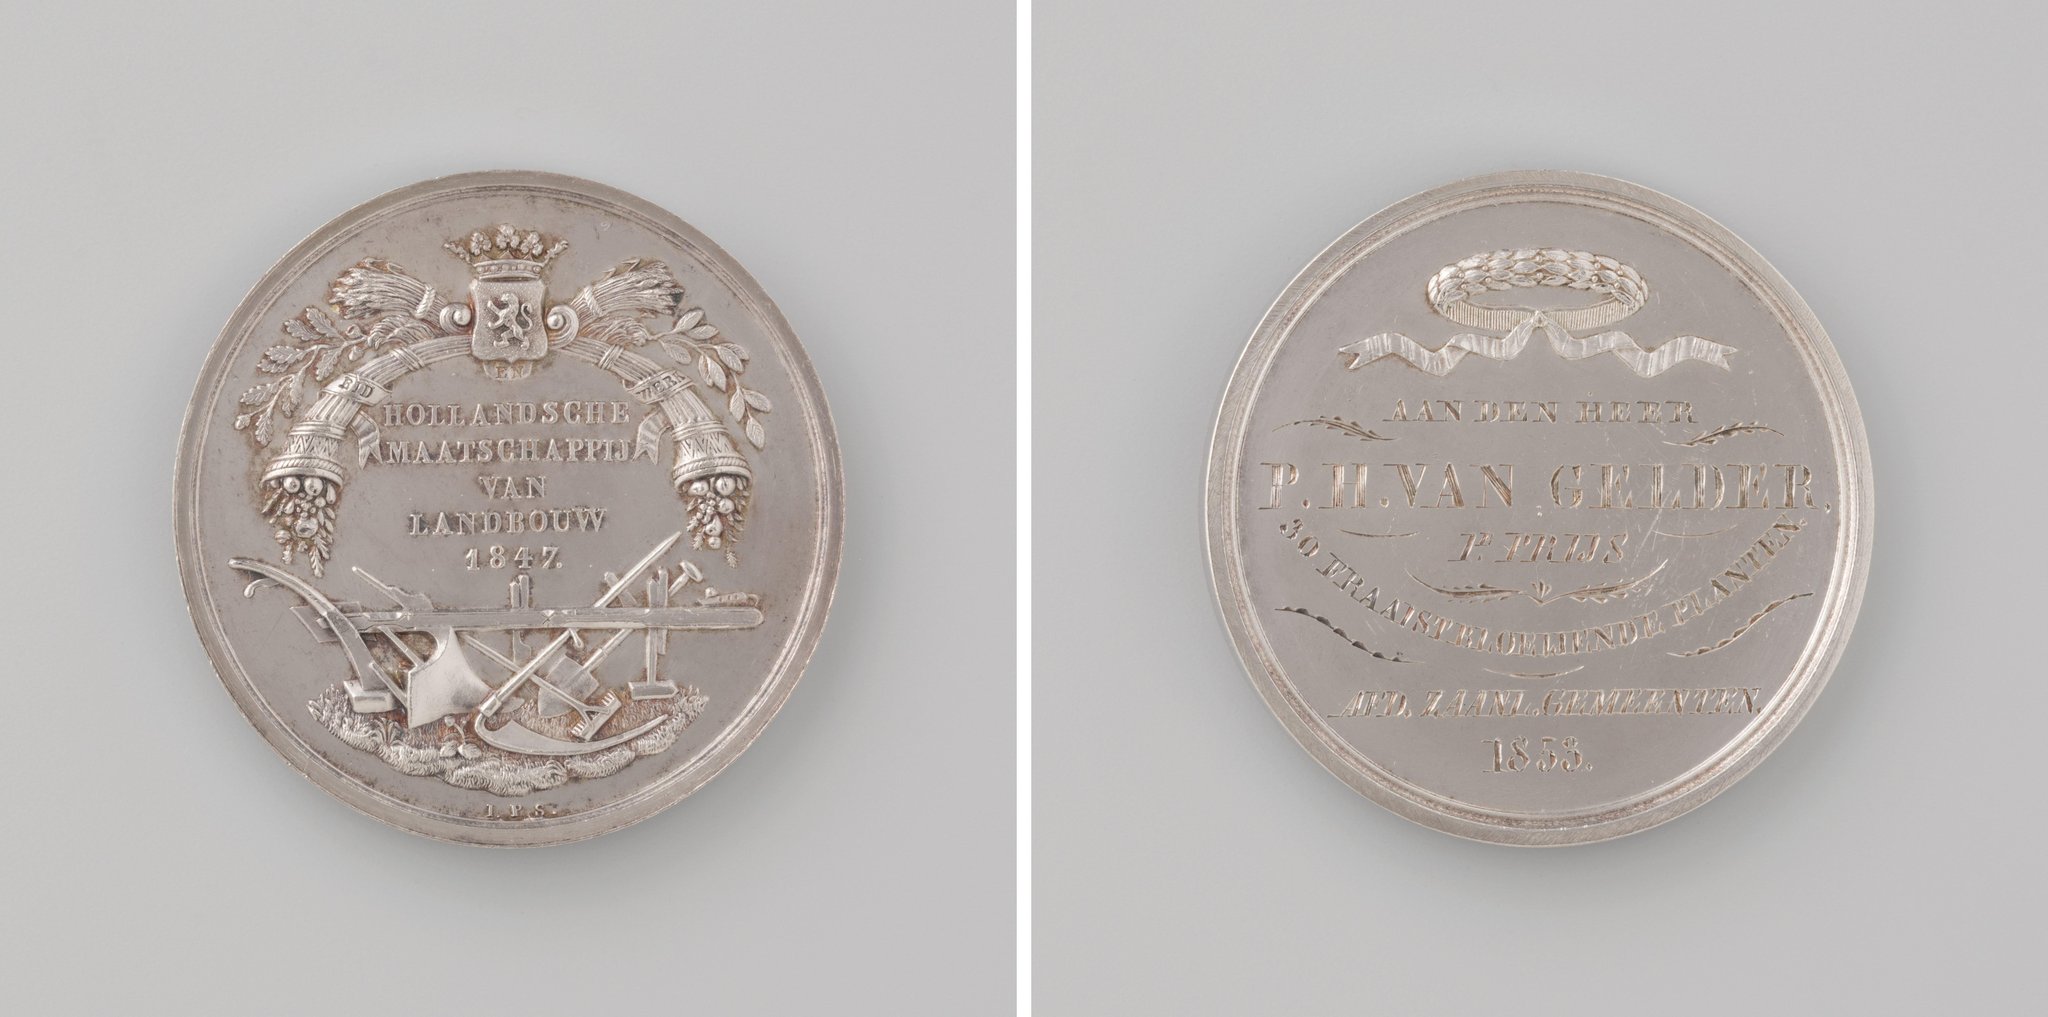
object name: medal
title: Afdeling Zaanlandse gemeenten van de Hollandsche Maatschappij van Landbouw, penning als eerste prijs uitgereikt aan P.H. van Gelder voor de dertig fraaiste planten in bloei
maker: johannis petrus schouberg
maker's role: die cutter, draughtsman, print maker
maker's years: 1798-1864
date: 1853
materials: silver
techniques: engraving, striking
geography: utrecht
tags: holland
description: Zilveren penning. Voorzijde: gekroond wapenschild liggend op twee korenschoven, twee omgekeerde, gevulde hoorns van overvloed, een eike- en een wilgetak boven opschrift en landbouwwerktuigen. Keerzijde: krans van olijftakken met lint boven opschriften